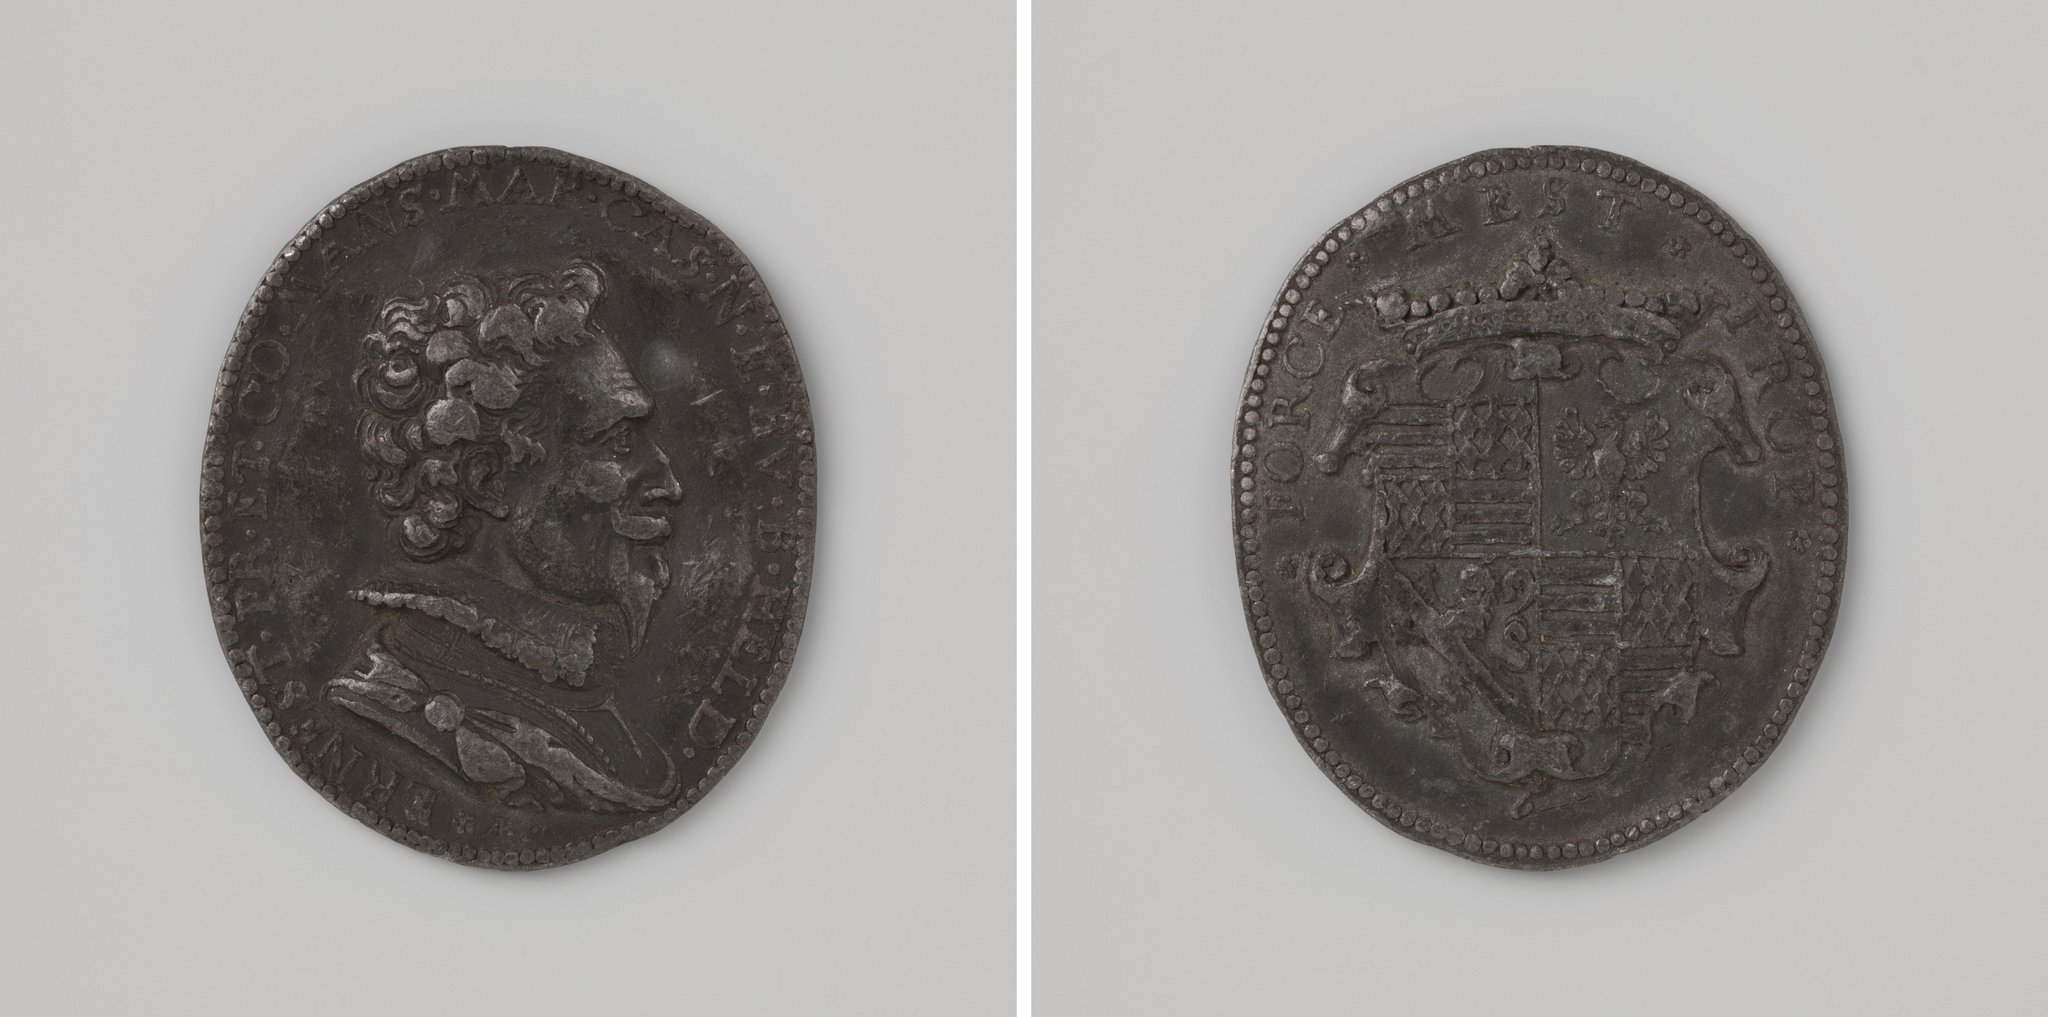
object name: history medal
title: Ernst van Mansfeld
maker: Anonymous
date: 1600-1626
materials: tin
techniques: casting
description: Ovale tinnen penning, op de voorzijde het borstbeeld van Van Mansfeld naar rechts met omschrift, op de keerzijde een gekroond versierd wapenschild met omschrift.